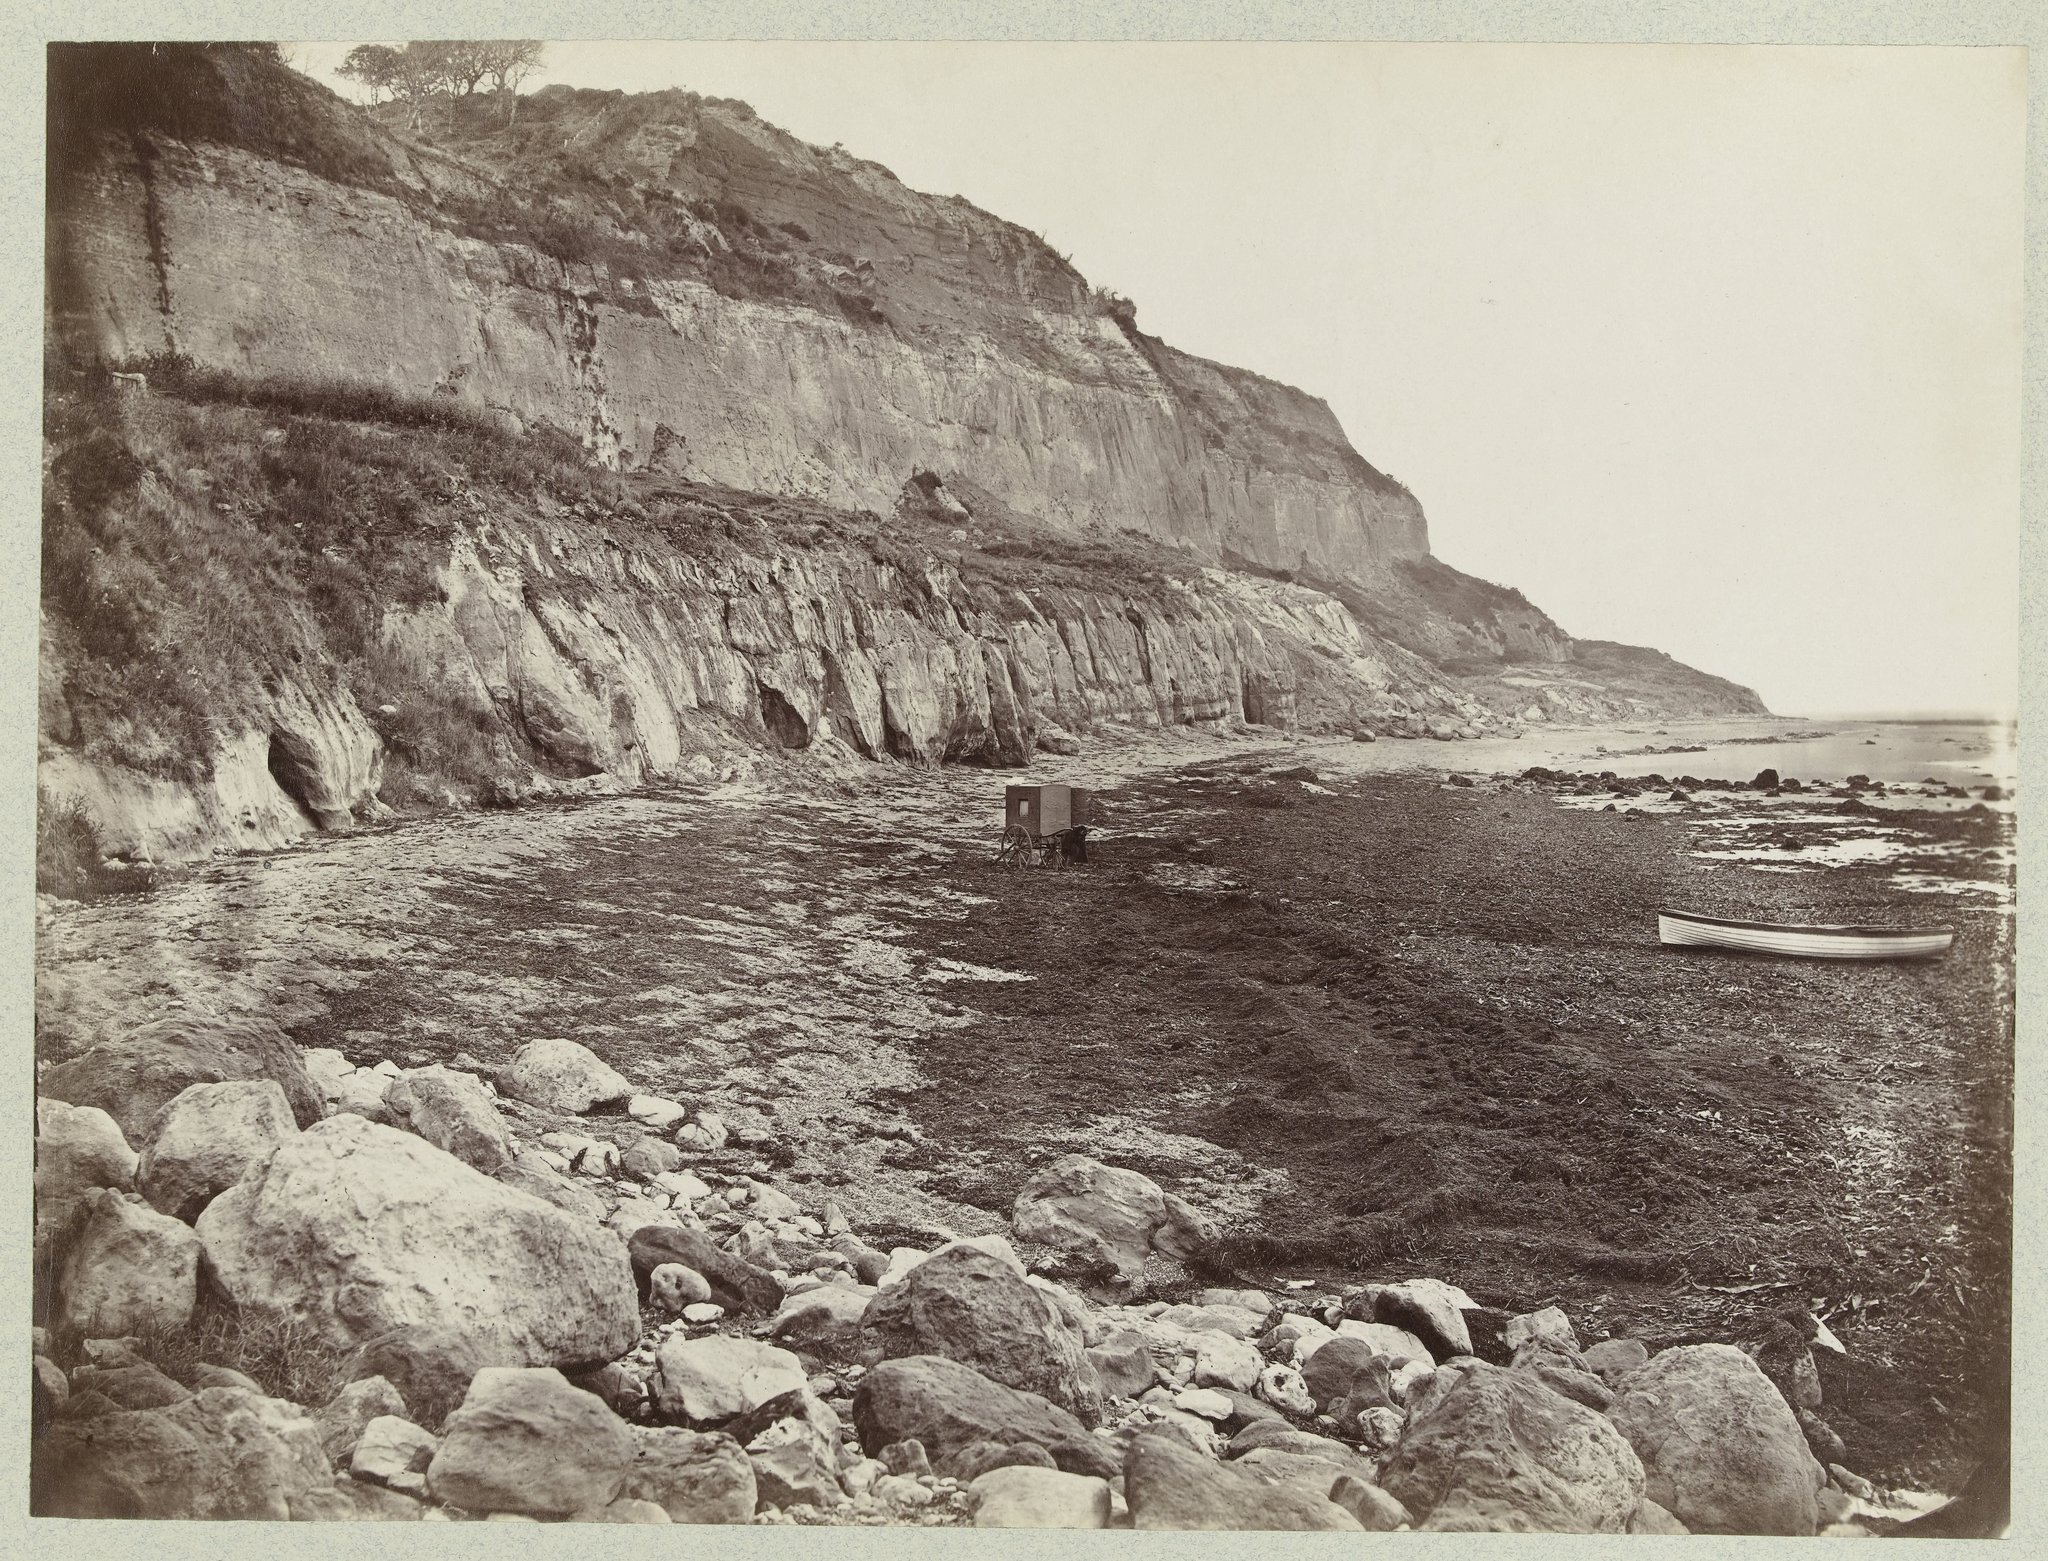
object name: photograph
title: Rotsachtig kustlandschap met boot en kar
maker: Anonymous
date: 1850-1875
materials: paper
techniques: albumen print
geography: france